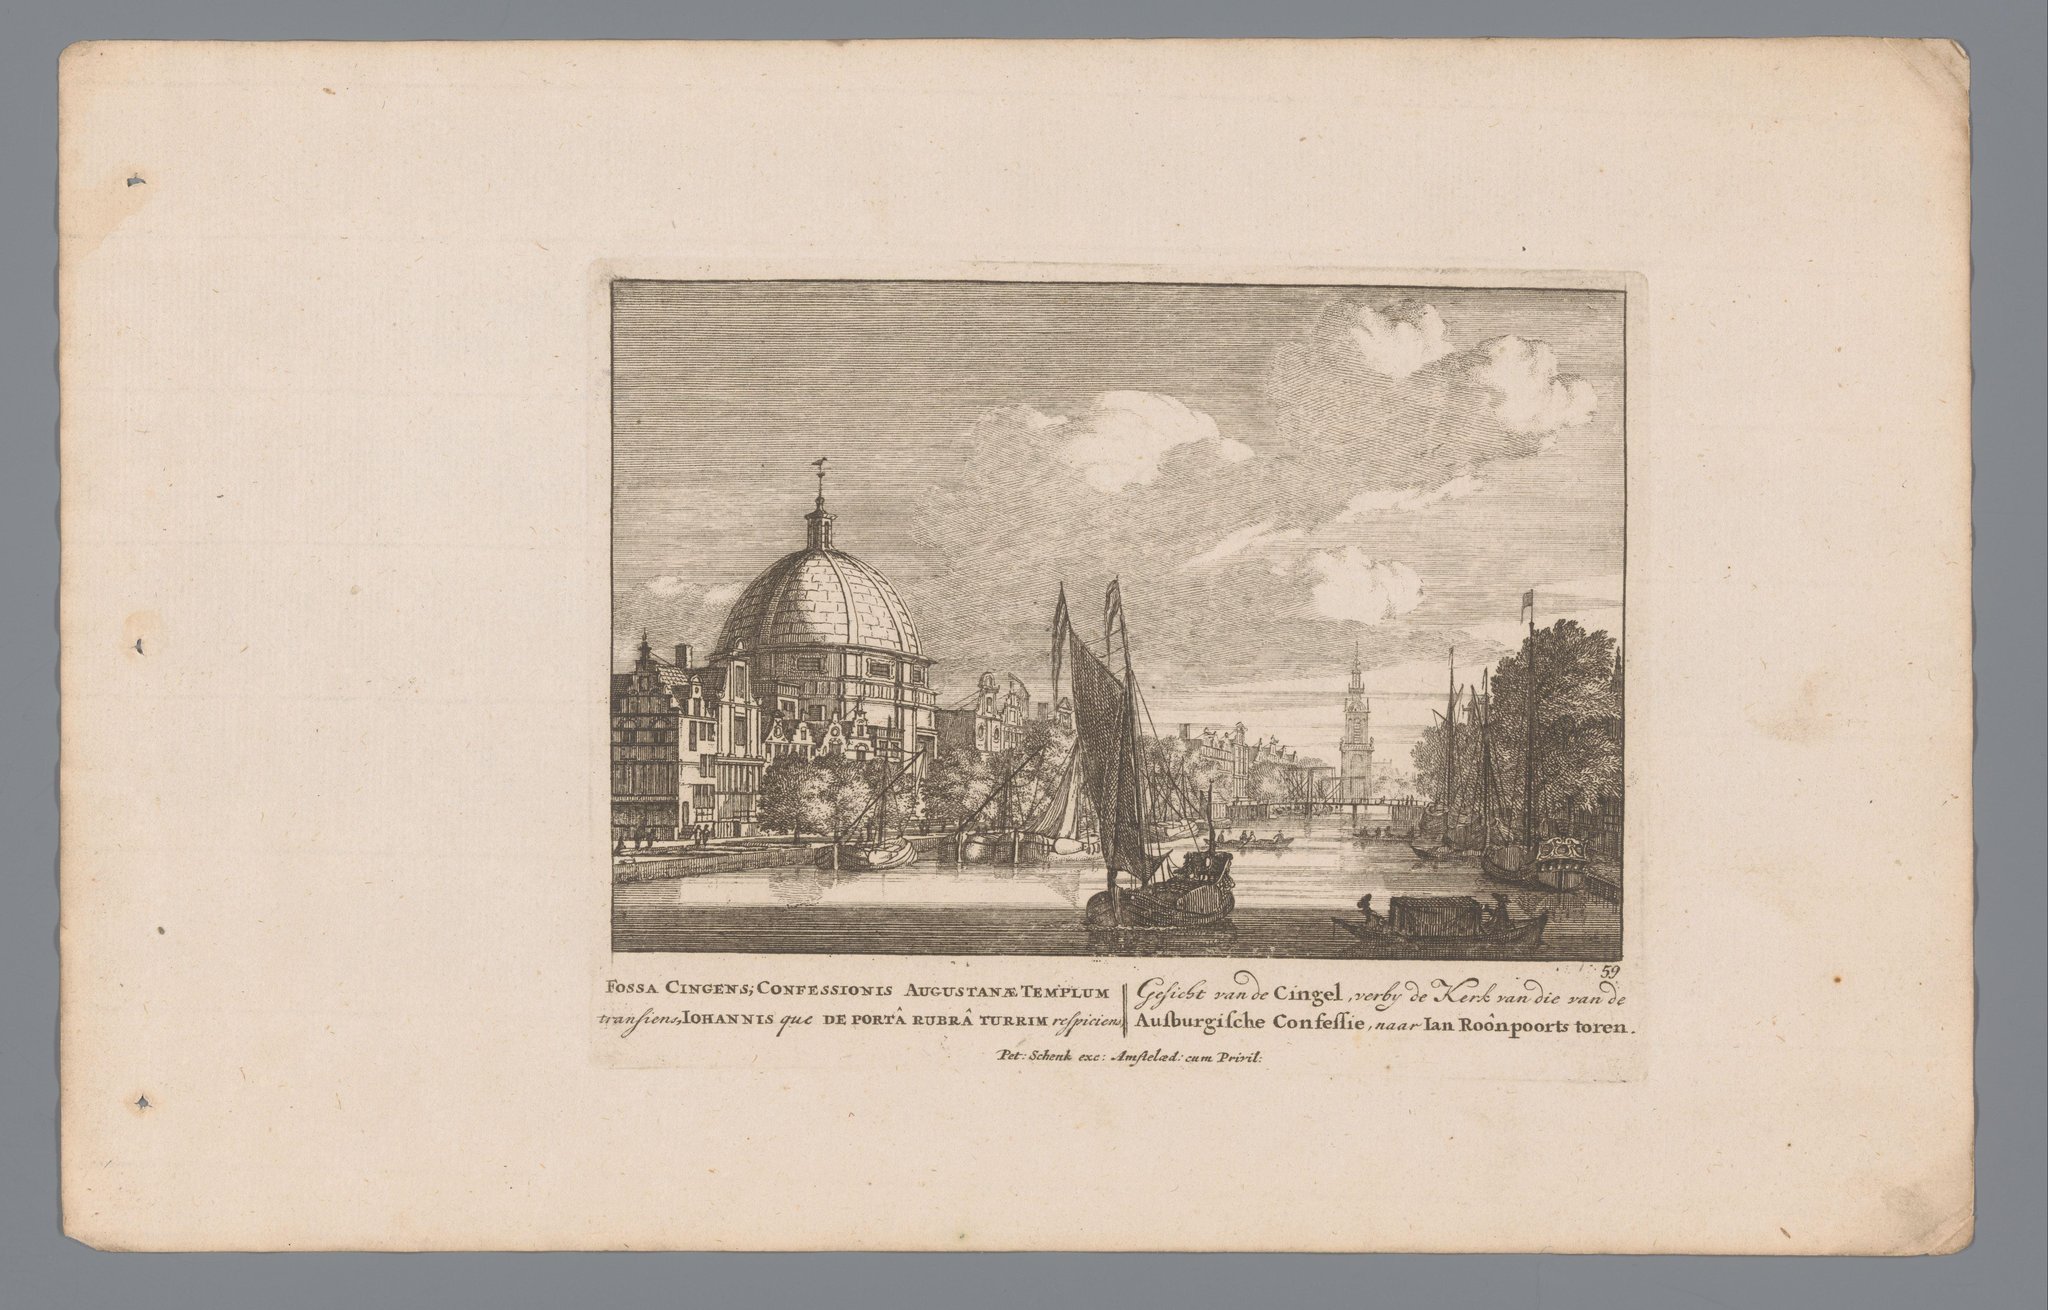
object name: print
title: Gezicht op de Singel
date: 1680-1700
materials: paper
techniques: etching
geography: amsterdam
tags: canals, waters (in city), amsterdam